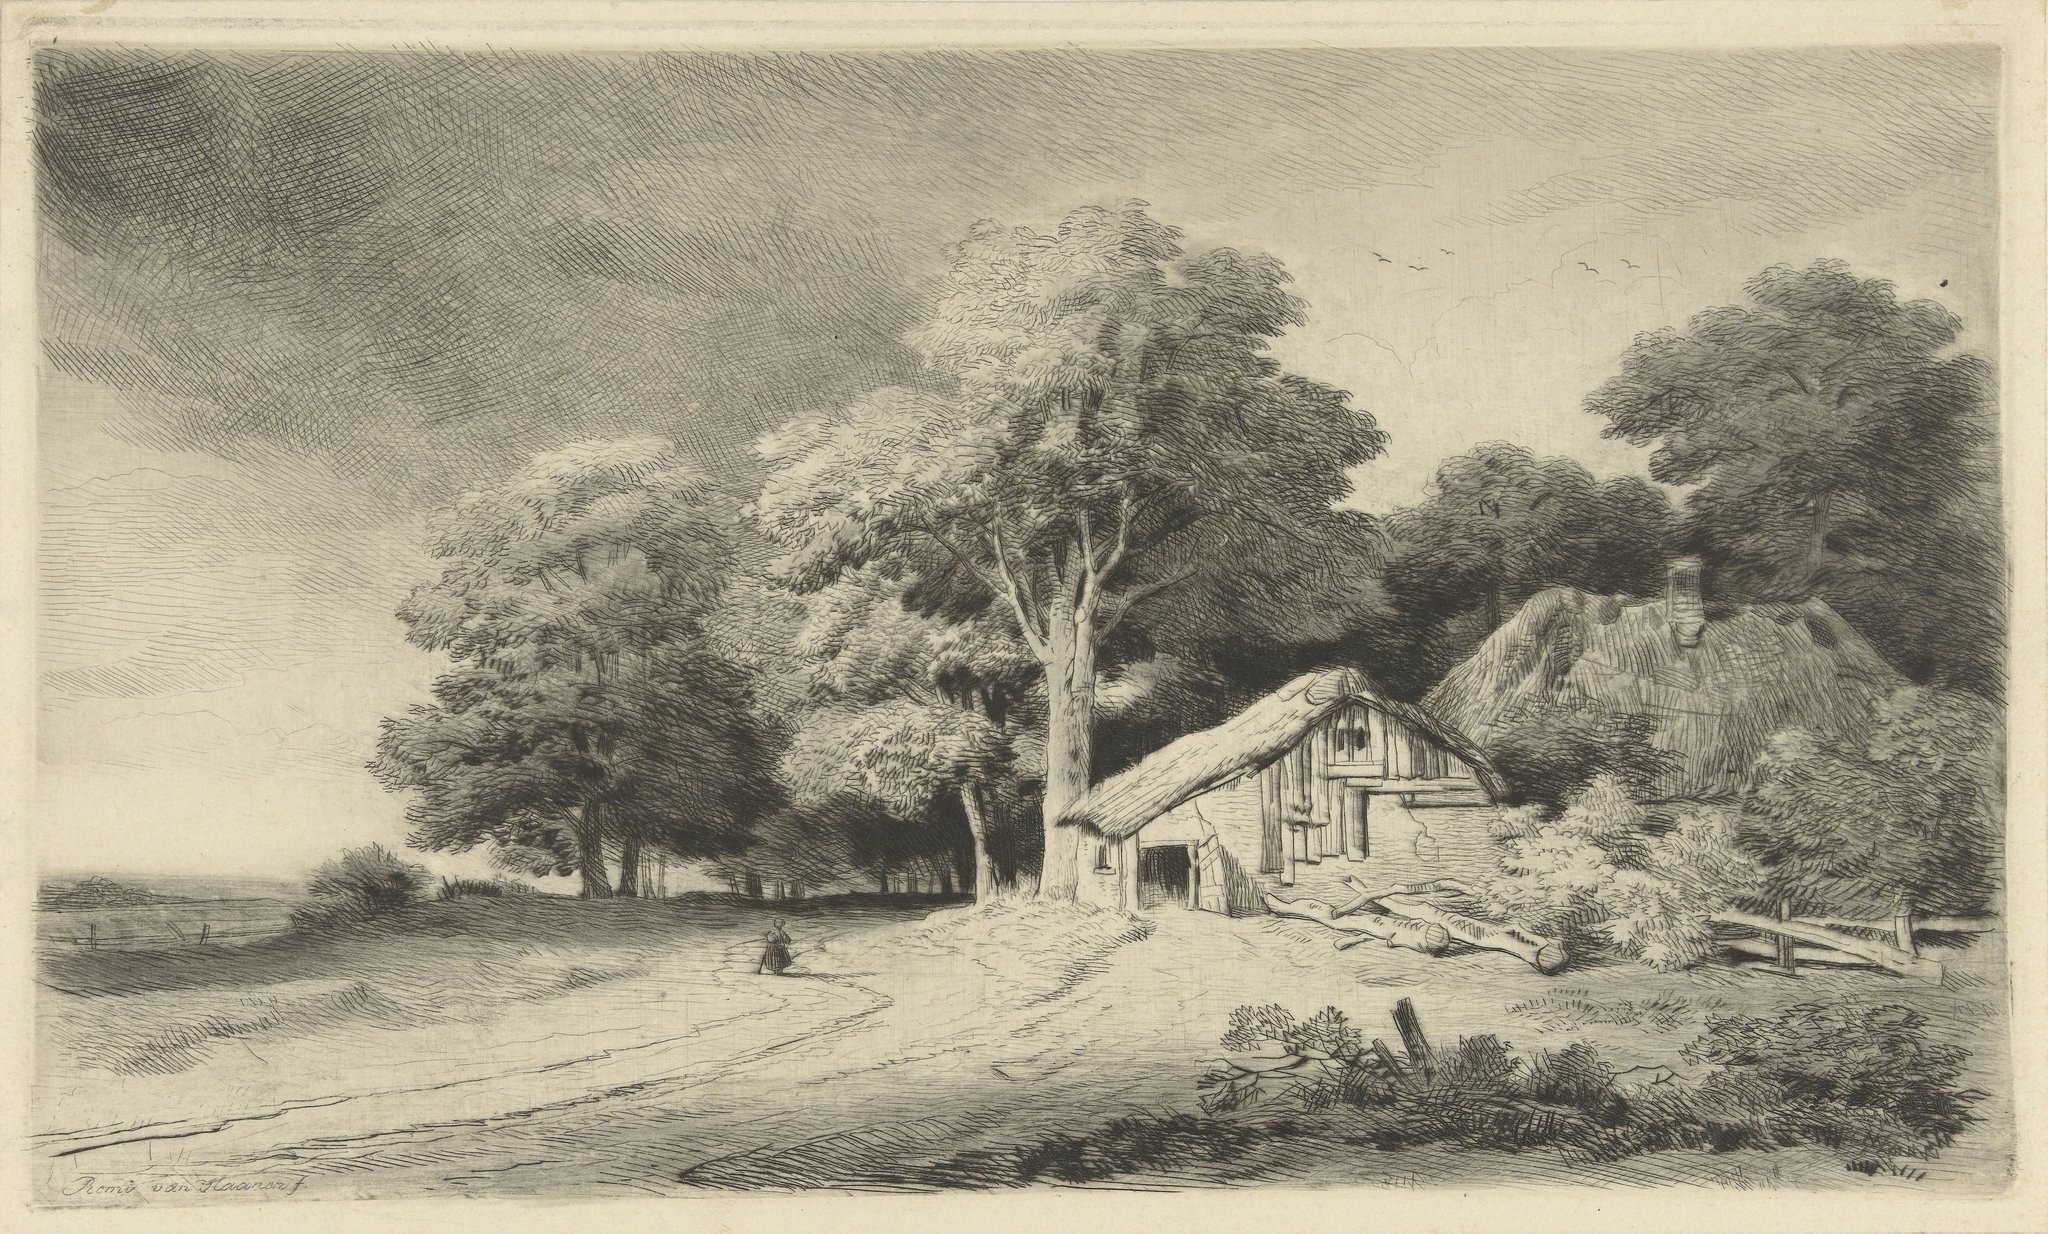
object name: print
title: Boerderij aan een weg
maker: remigius adrianus haanen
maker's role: draughtsman, painter, print maker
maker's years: 1812-1894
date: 1827-1879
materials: paper, pencil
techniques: aquatint, drypoint, etching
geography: austria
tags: farm or solitary house in landscape (+ city(-scape) with figures, staffage)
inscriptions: collector's mark: Lugt 2228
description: Een weg met een figuur bij een boerderij en een schuur aan een bosrand.